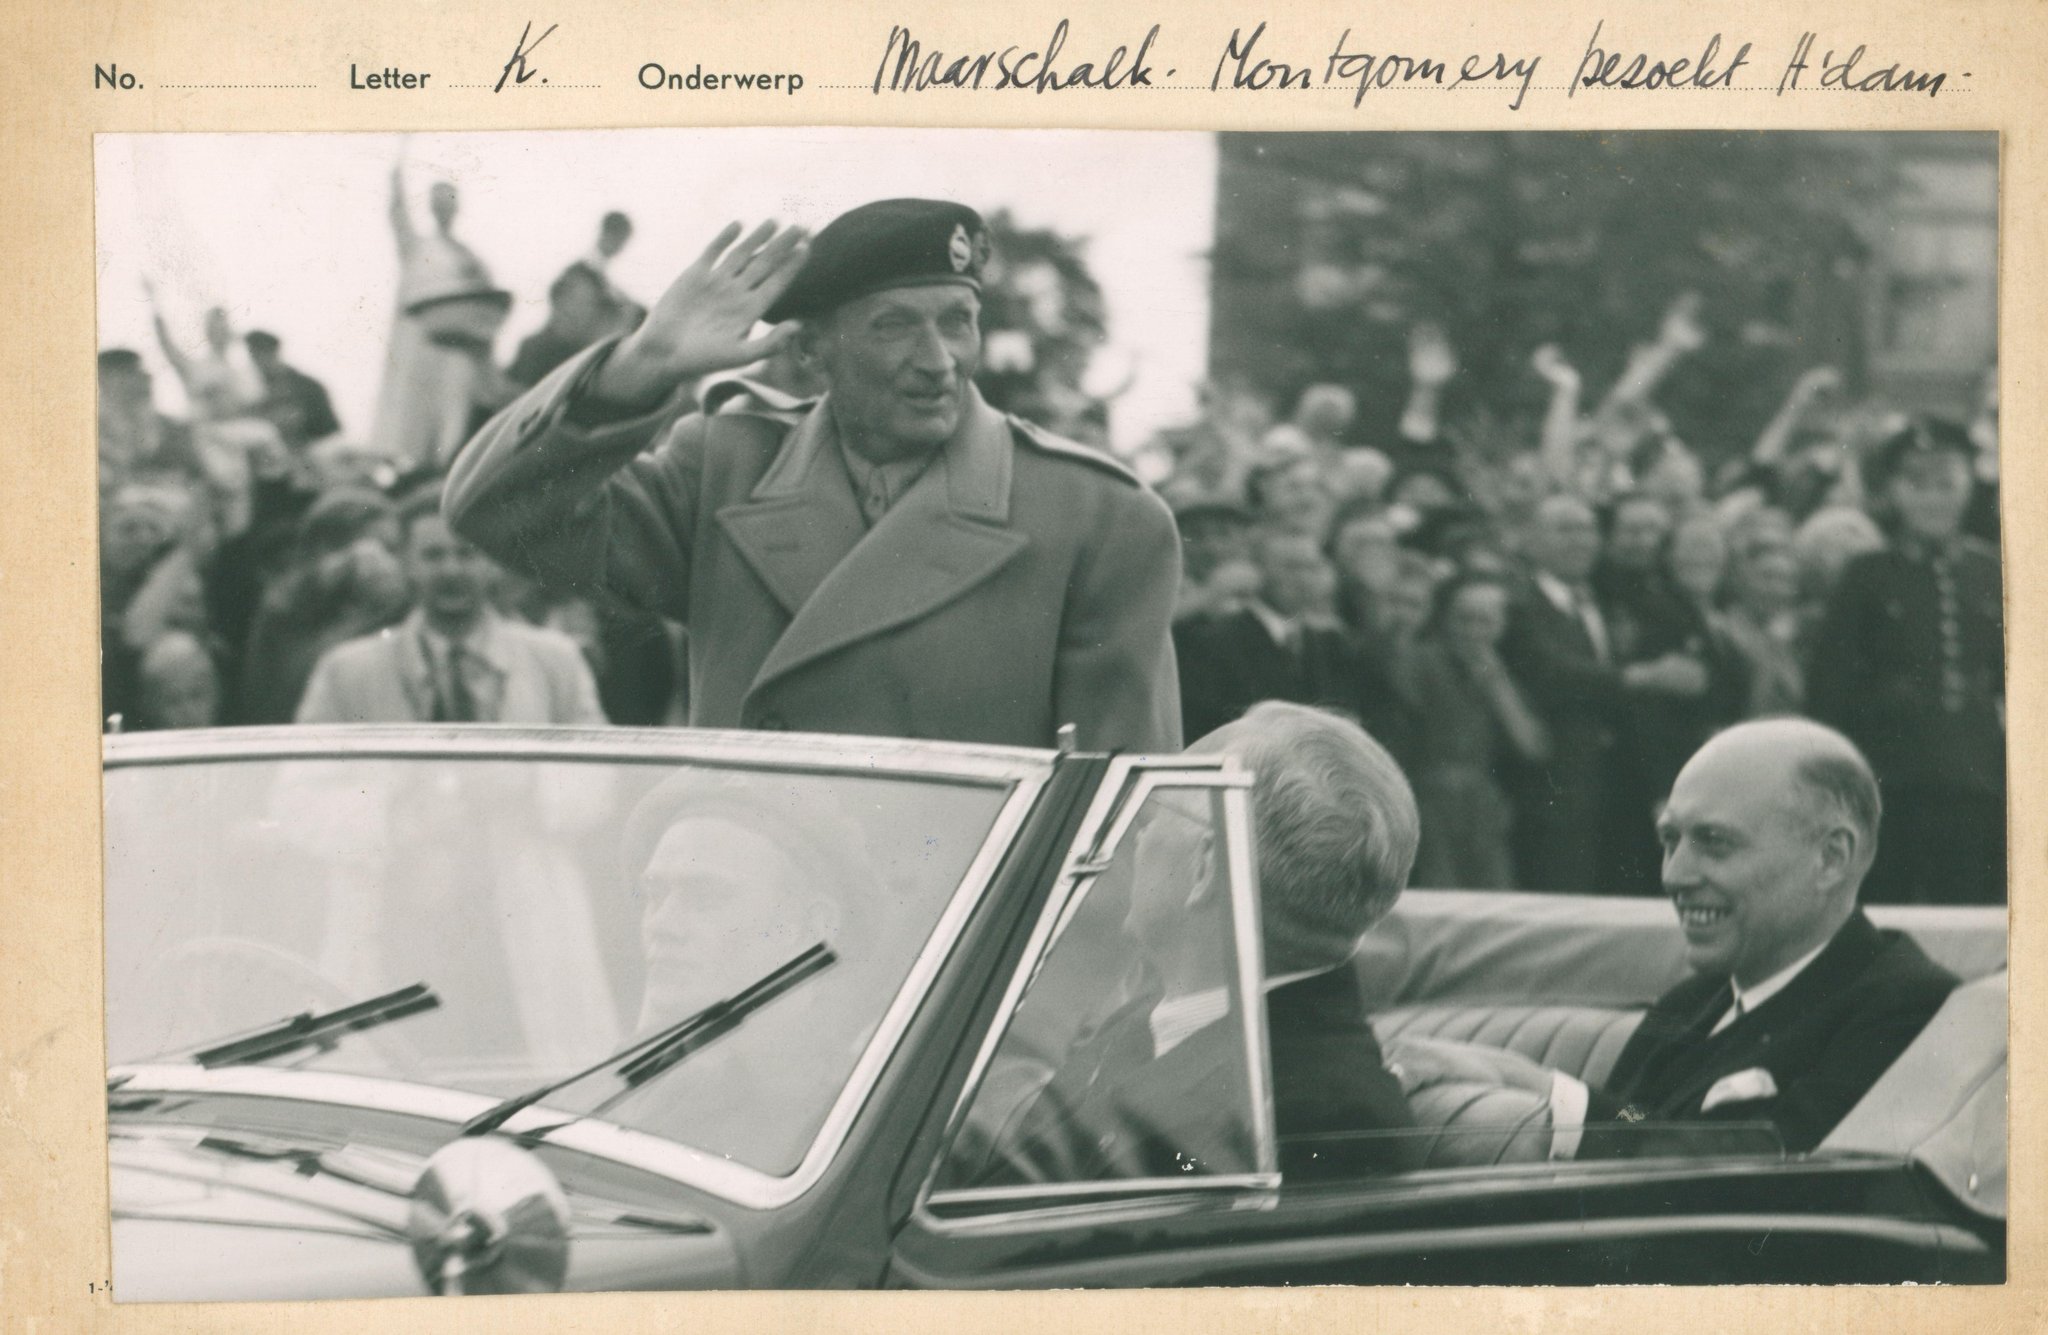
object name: documentary photograph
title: Montgomery in bevrijd Amsterdam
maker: Anonymous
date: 1945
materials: photographic support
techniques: photography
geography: amsterdam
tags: london, amsterdam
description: De Engelse veldmaarschalk Montgomery doet per open auto zijn intocht in Amsterdam en wordt daarbij uitbundig toegejuicht door het massaal aanwezige publiek.